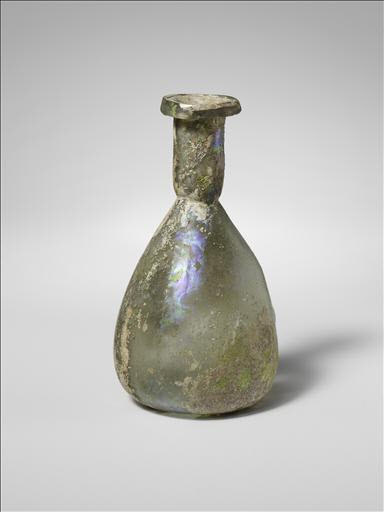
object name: perfume bottle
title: Glass perfume bottle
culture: roman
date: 1-200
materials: glass